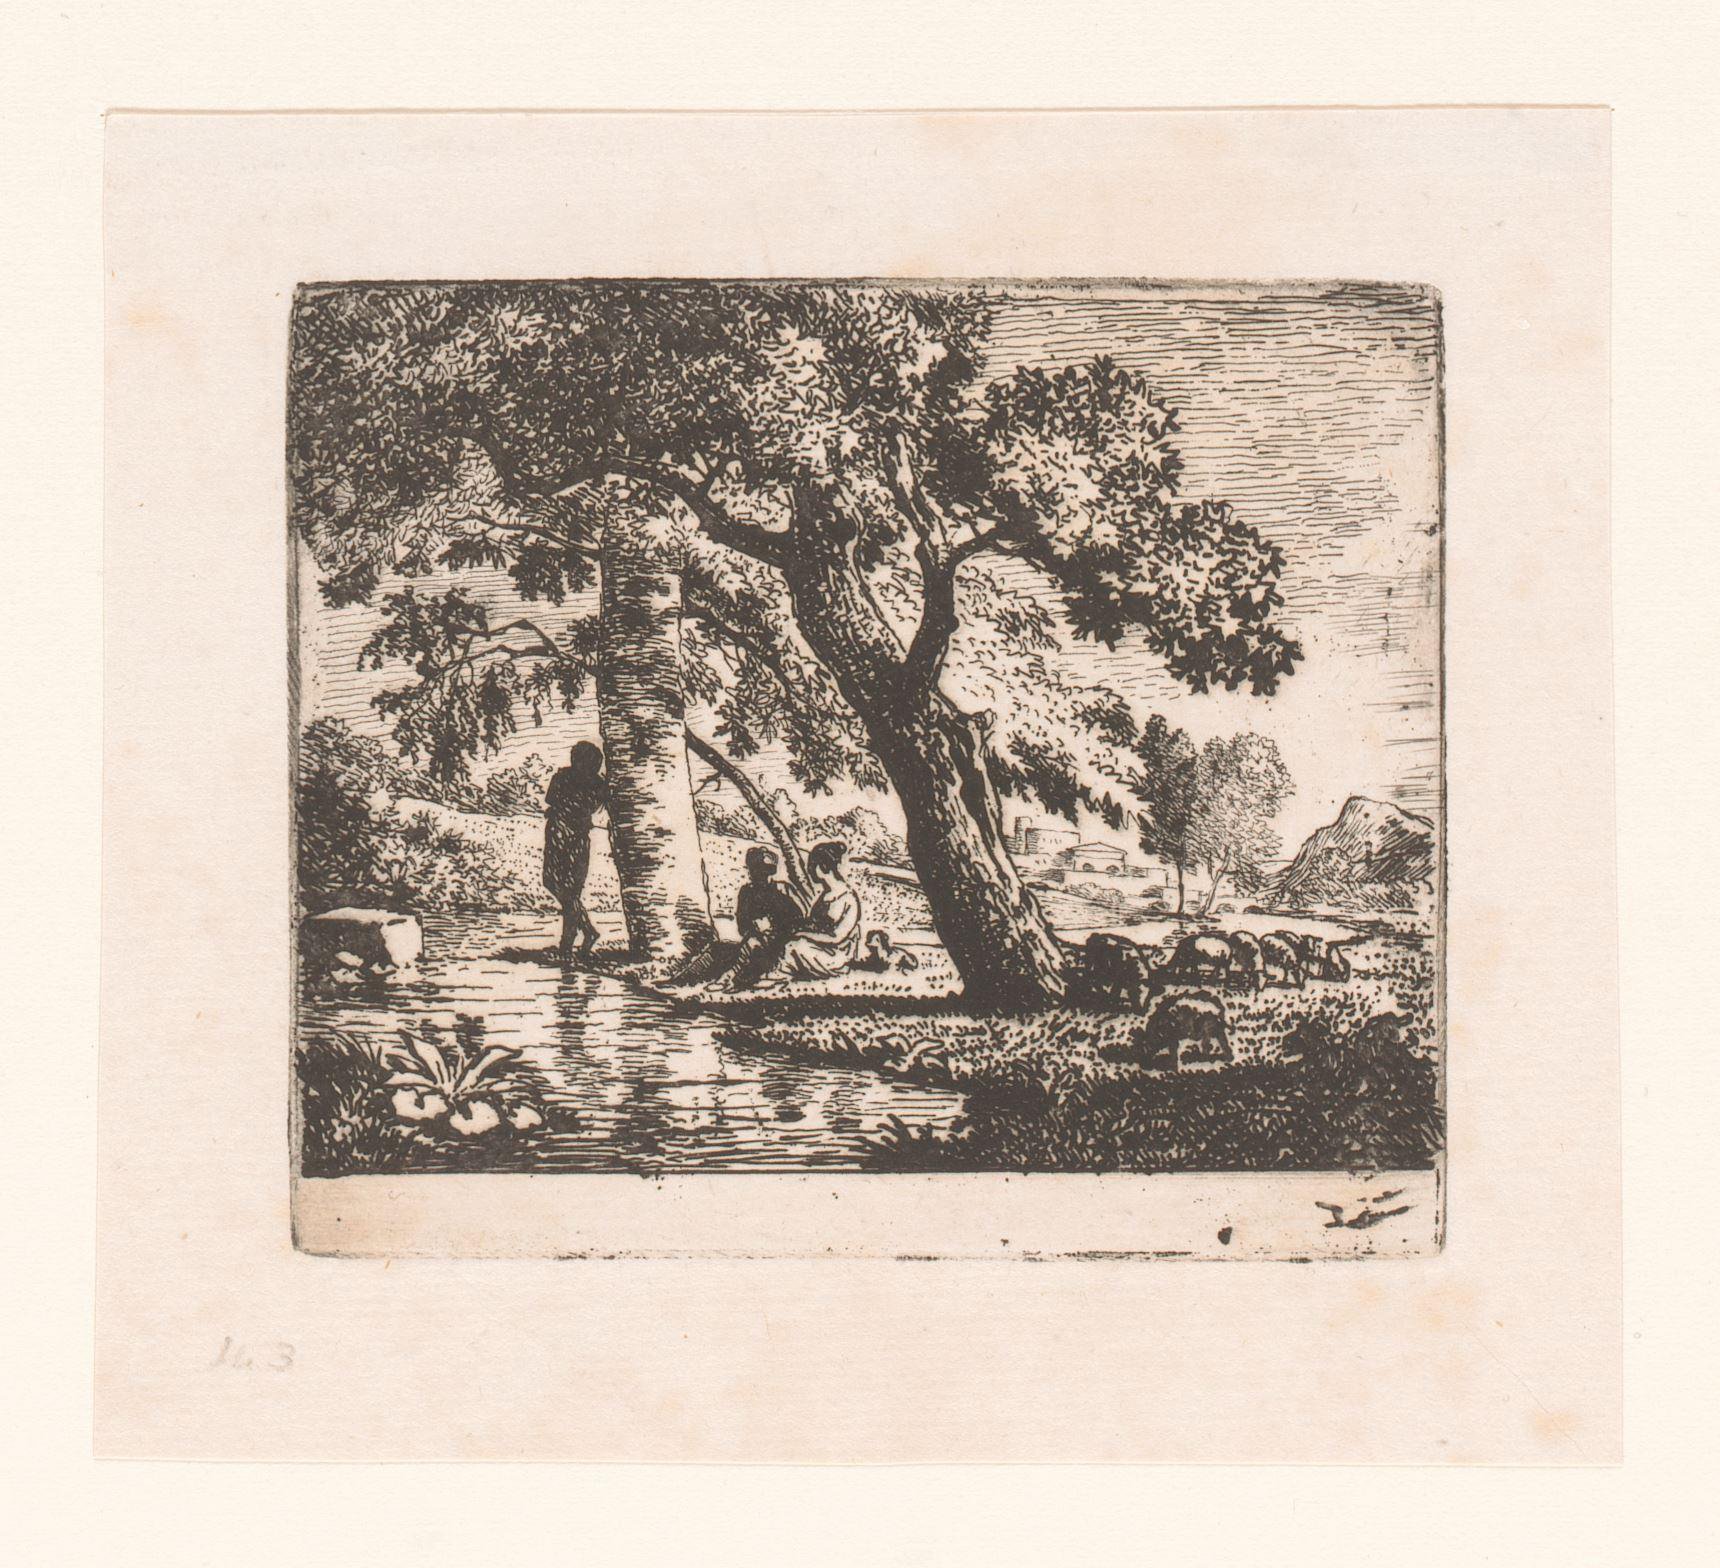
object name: print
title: Drie figuren bij een boom aan het water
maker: jean louis demarne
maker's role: draughtsman, painter, print maker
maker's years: 1752-1829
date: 1762-1829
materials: paper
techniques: etching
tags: herding, herdsman, herdswoman, shepherd, shepherdess, cowherd, etc., sheep, landscapes with waters, waterscapes, seascapes (in the temperate zone) (+ landscape with figures, staffage)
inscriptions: collector's mark: Lugt 2228